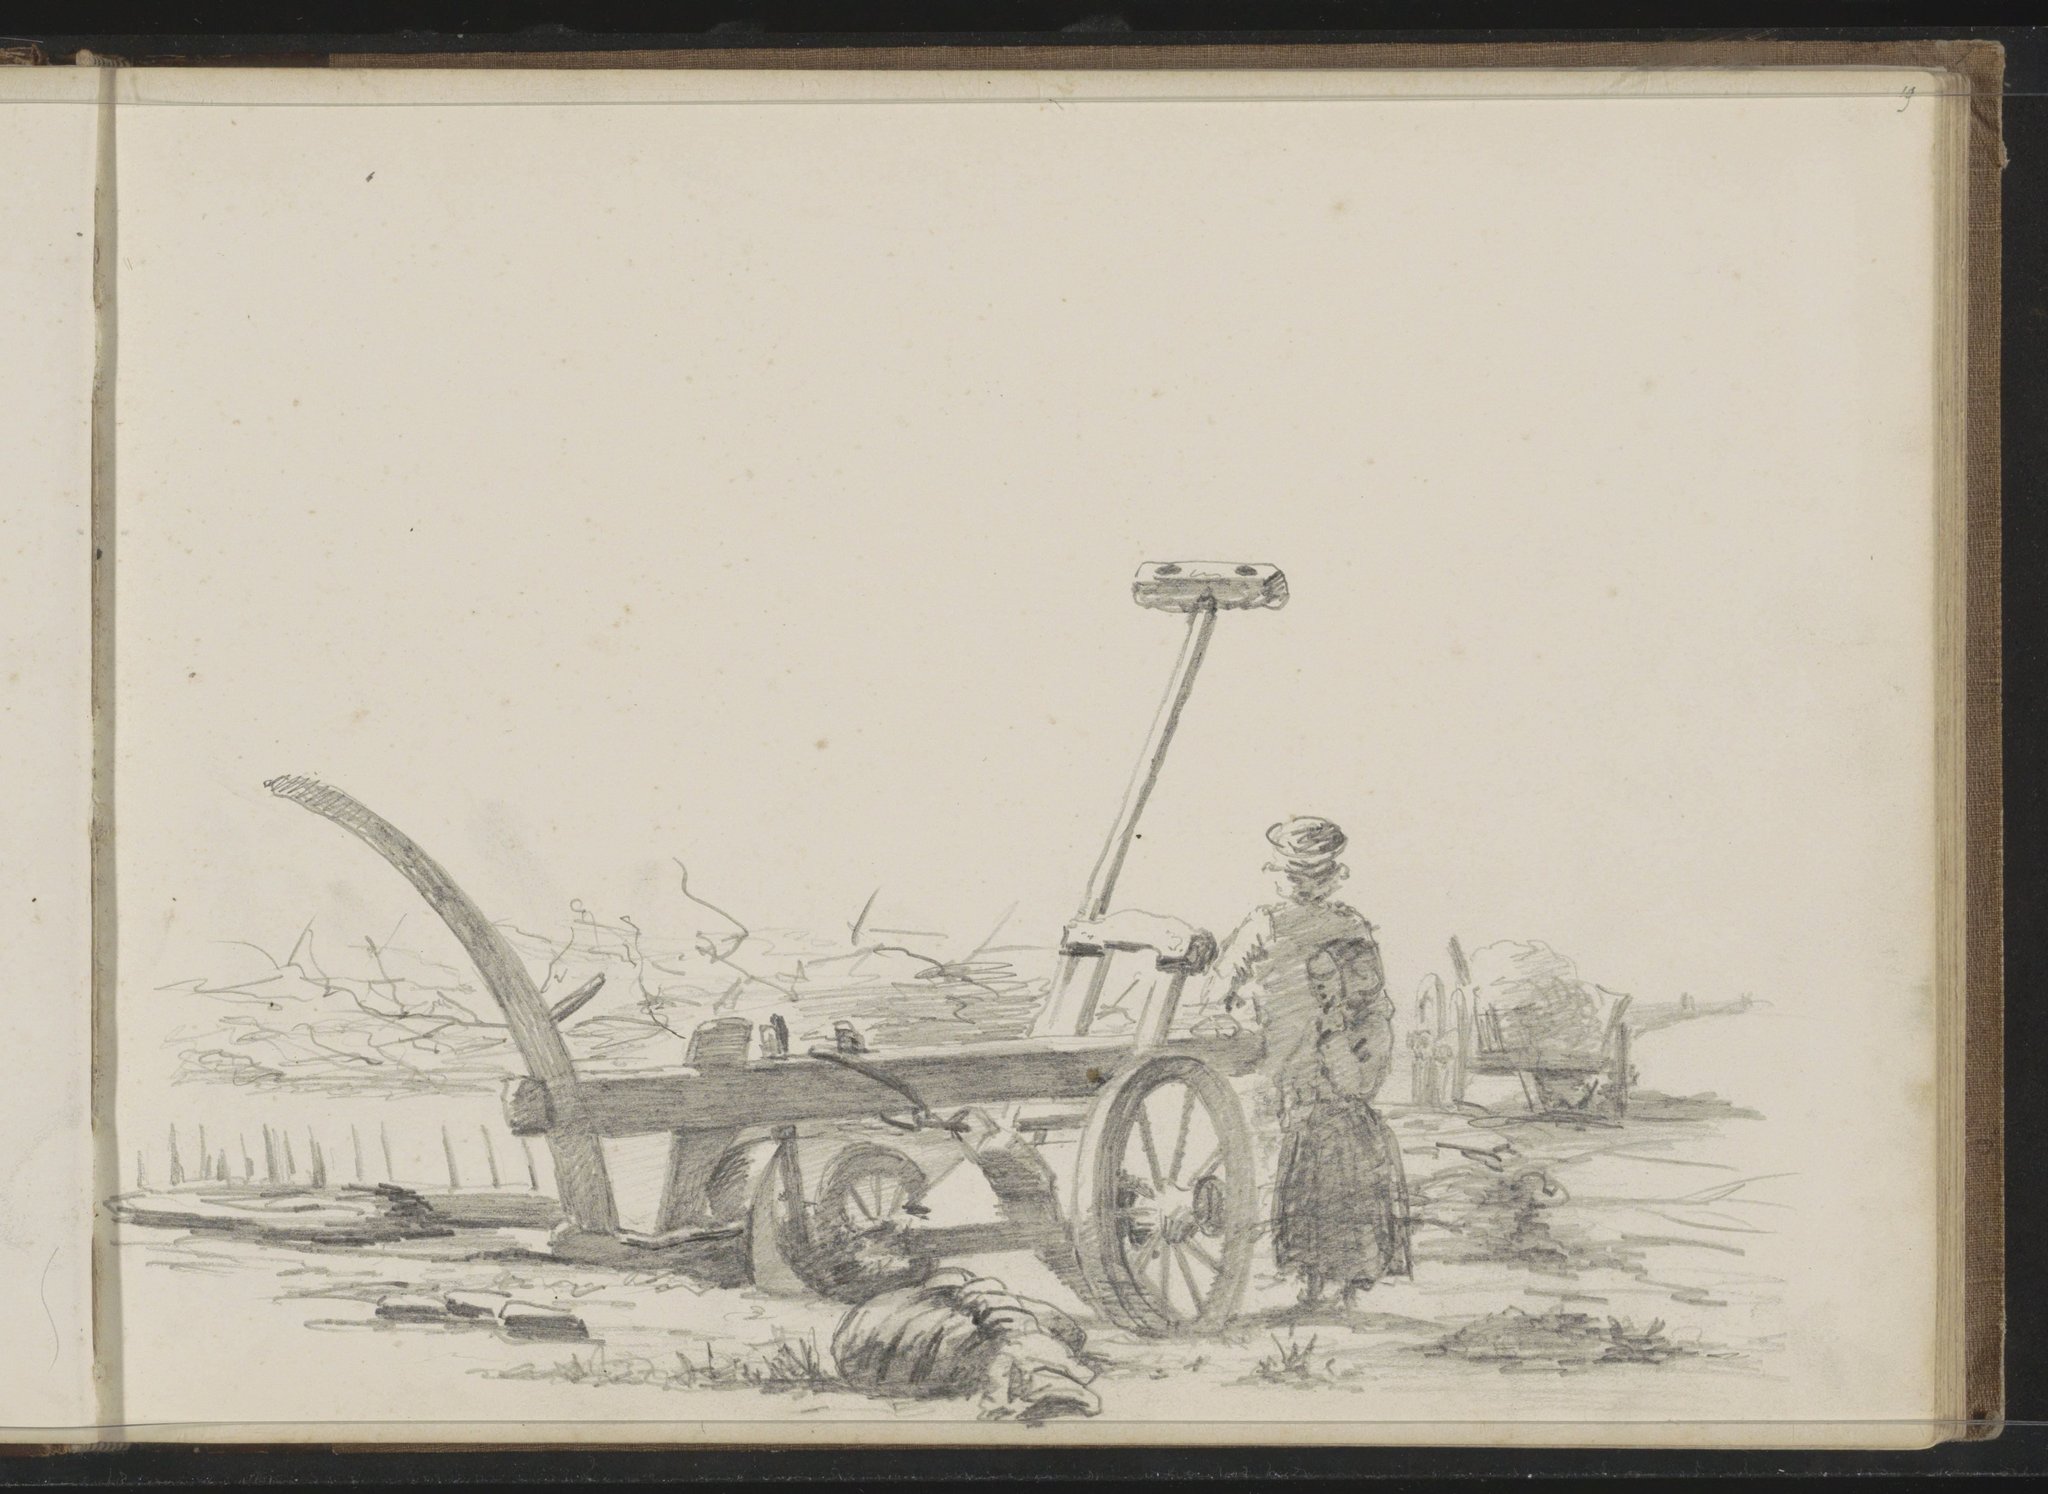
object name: sketchbook leaf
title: Boer en meisje bij een ploeg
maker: hendrik valkenburg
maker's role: draughtsman, painter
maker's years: 1826-1896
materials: paper, pencil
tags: farmers, agricultural implements: plough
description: Op de achtergrond een beladen wagen. Blad 19 recto uit een schetsboek met 77 bladen.